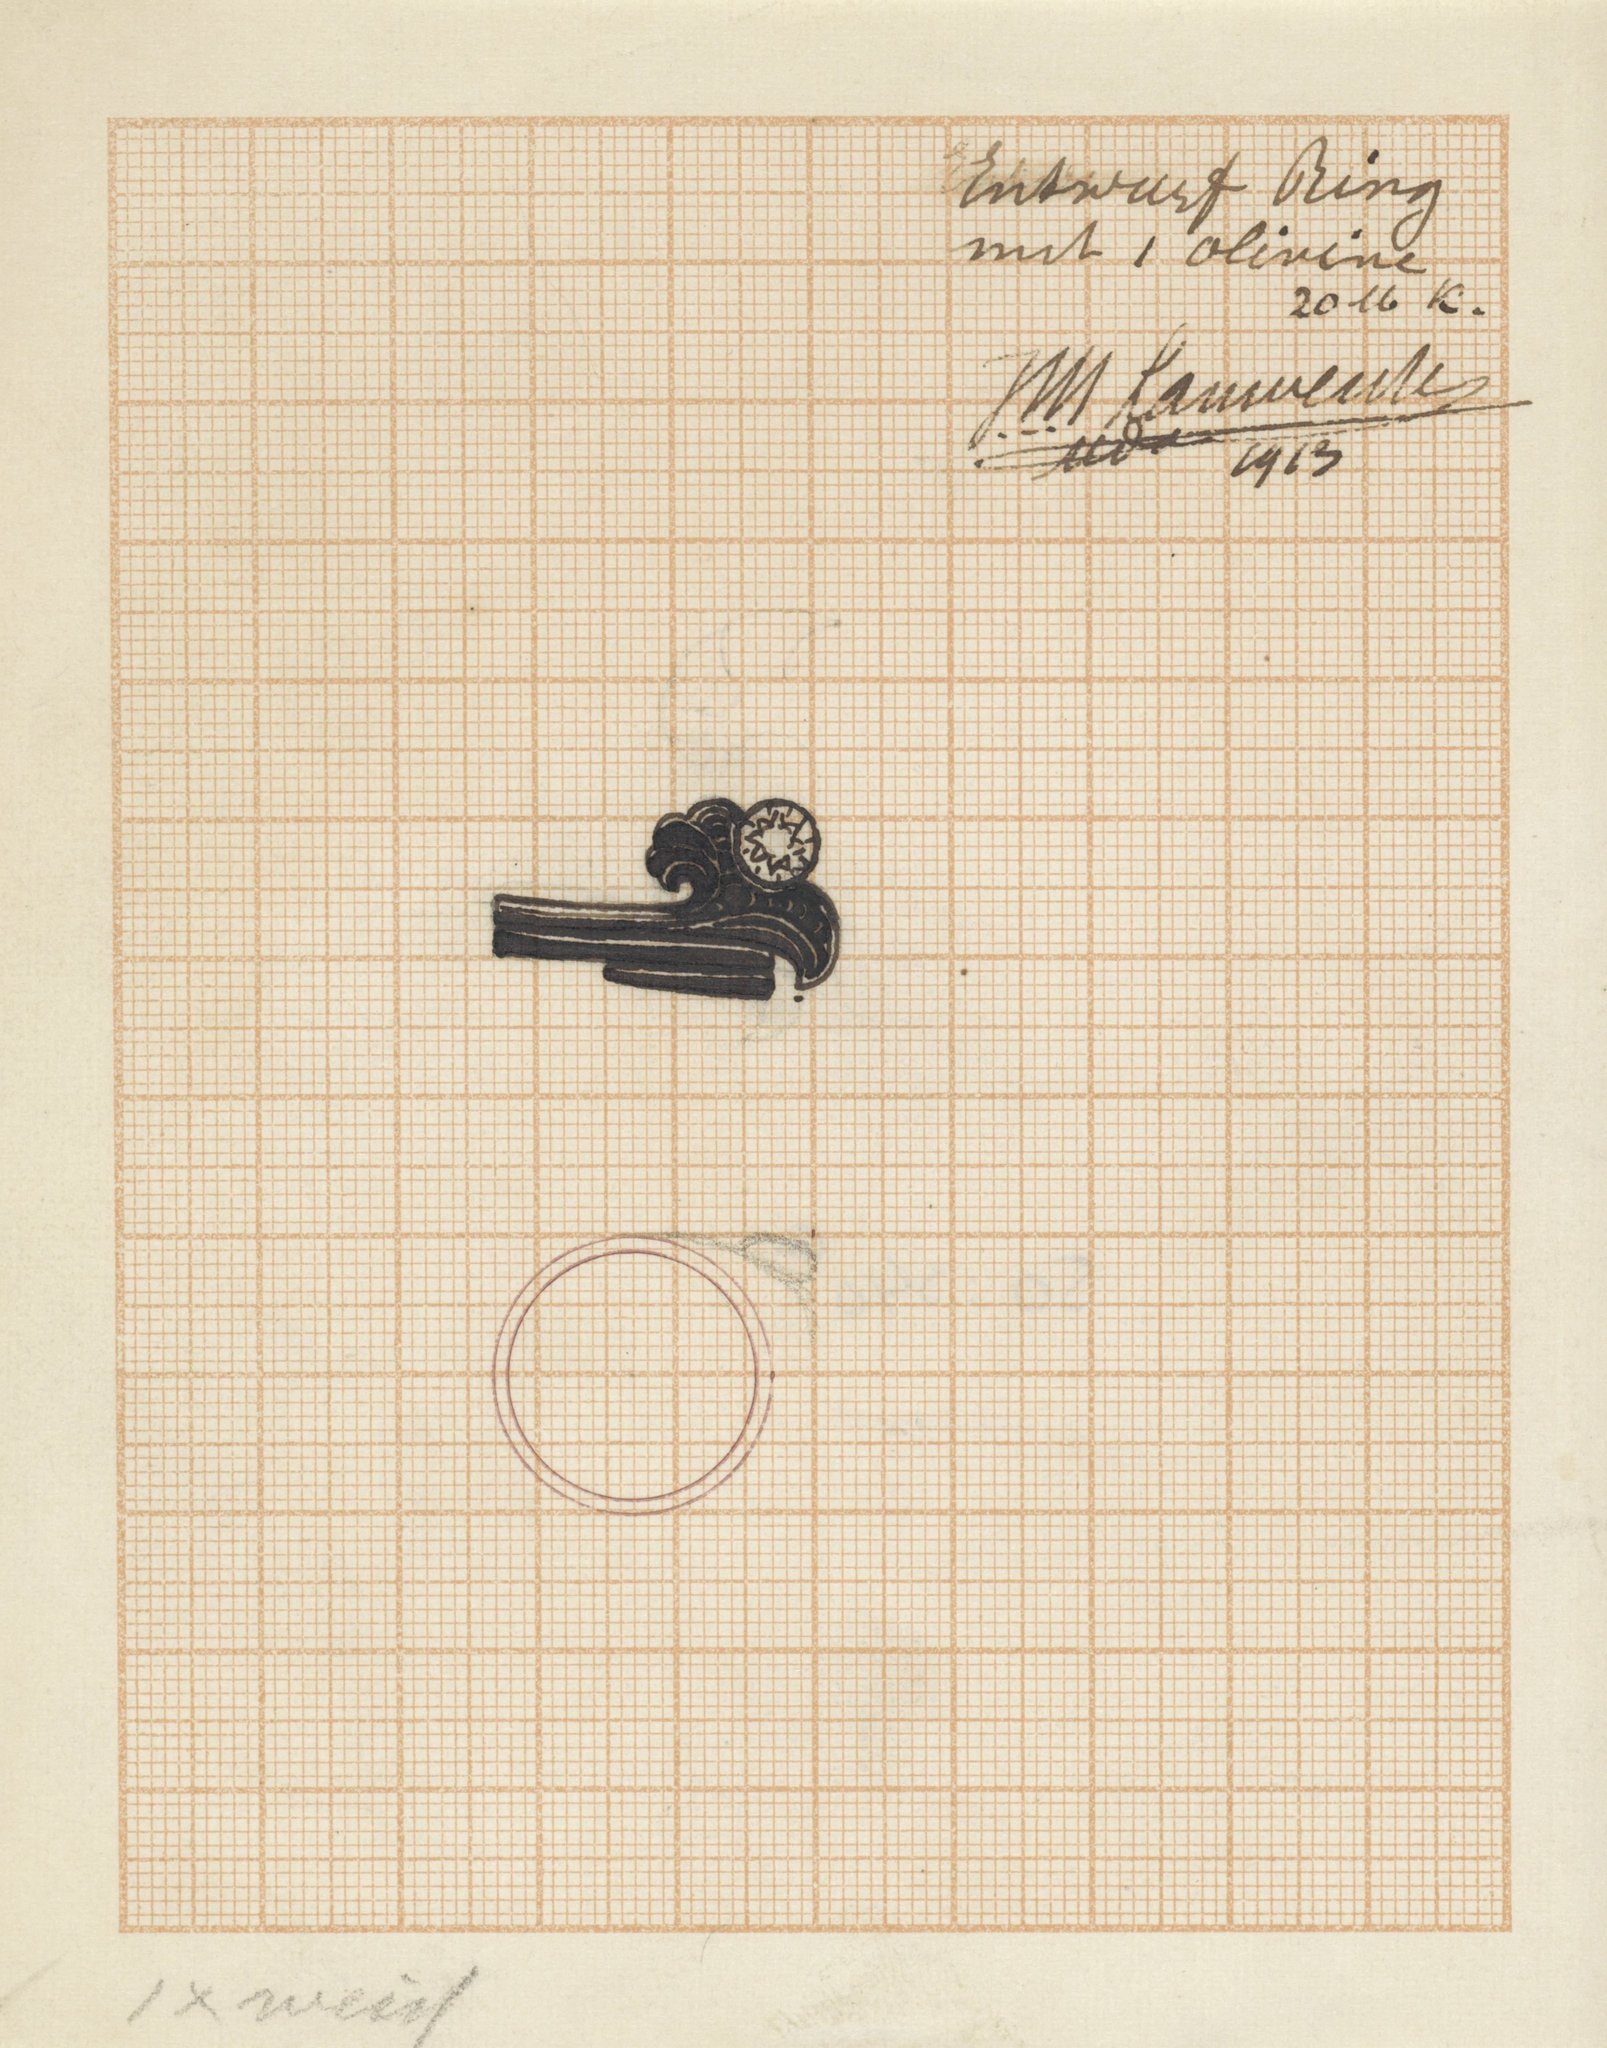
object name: drawing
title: Ontwerp voor een ring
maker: mathieu lauweriks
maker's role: designer, draughtsman, print maker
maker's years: 1864-1932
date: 1913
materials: ink, pencil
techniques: pen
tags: ring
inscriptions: date: ‘1913’